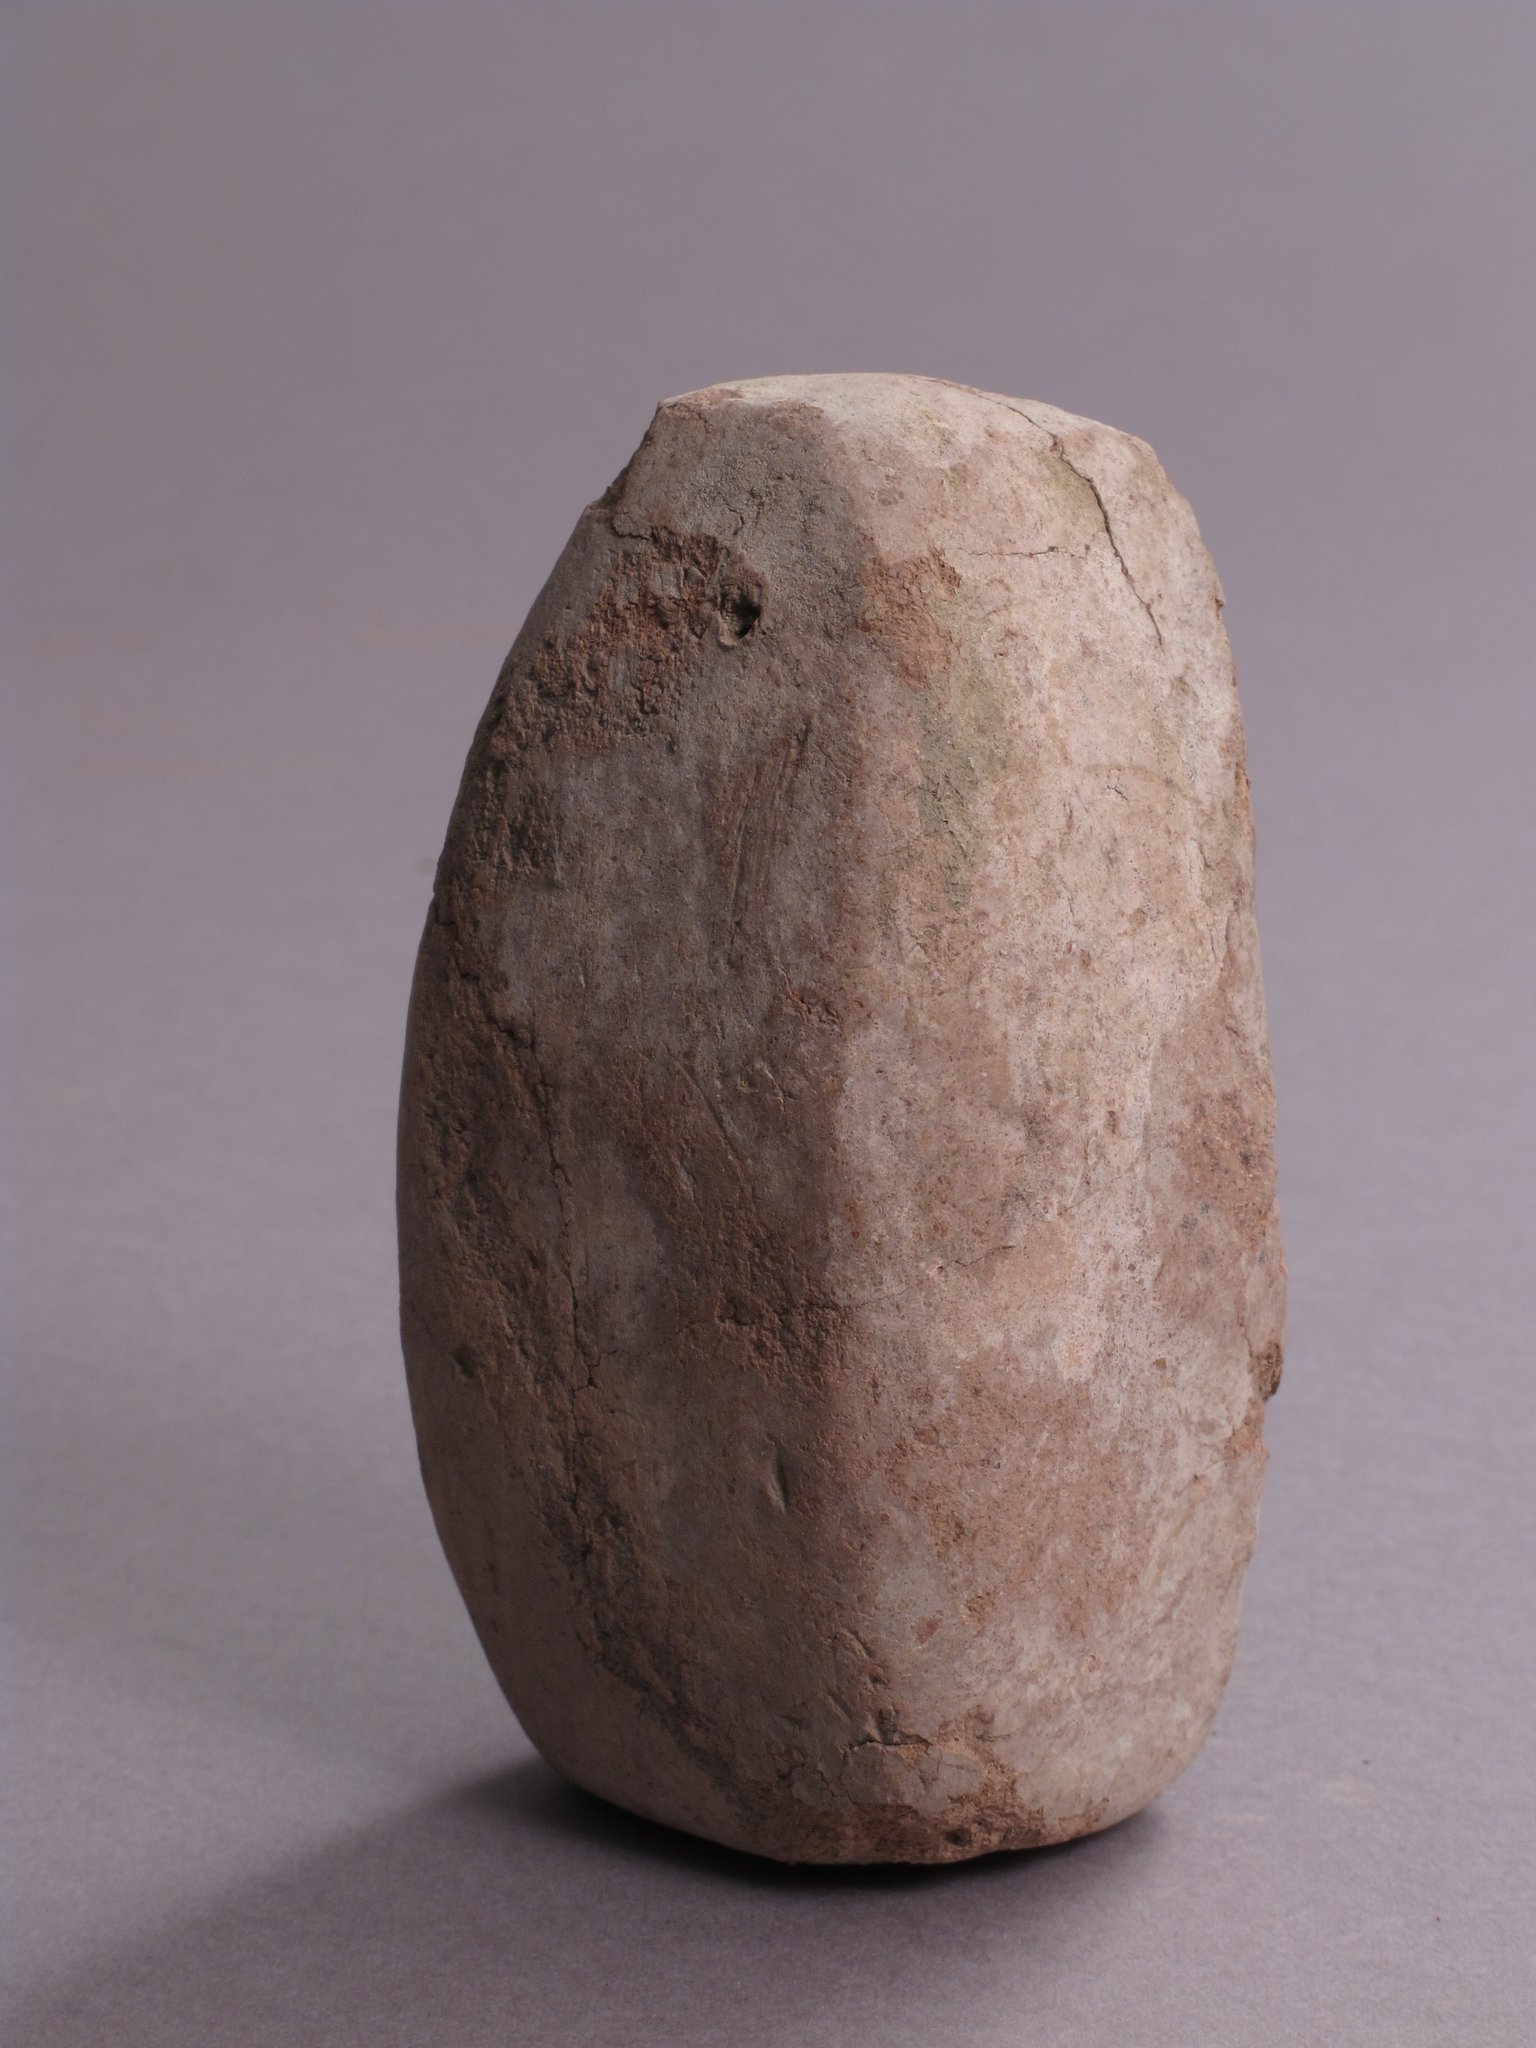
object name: loom weight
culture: coptic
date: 580-640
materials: earthenware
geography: egypt